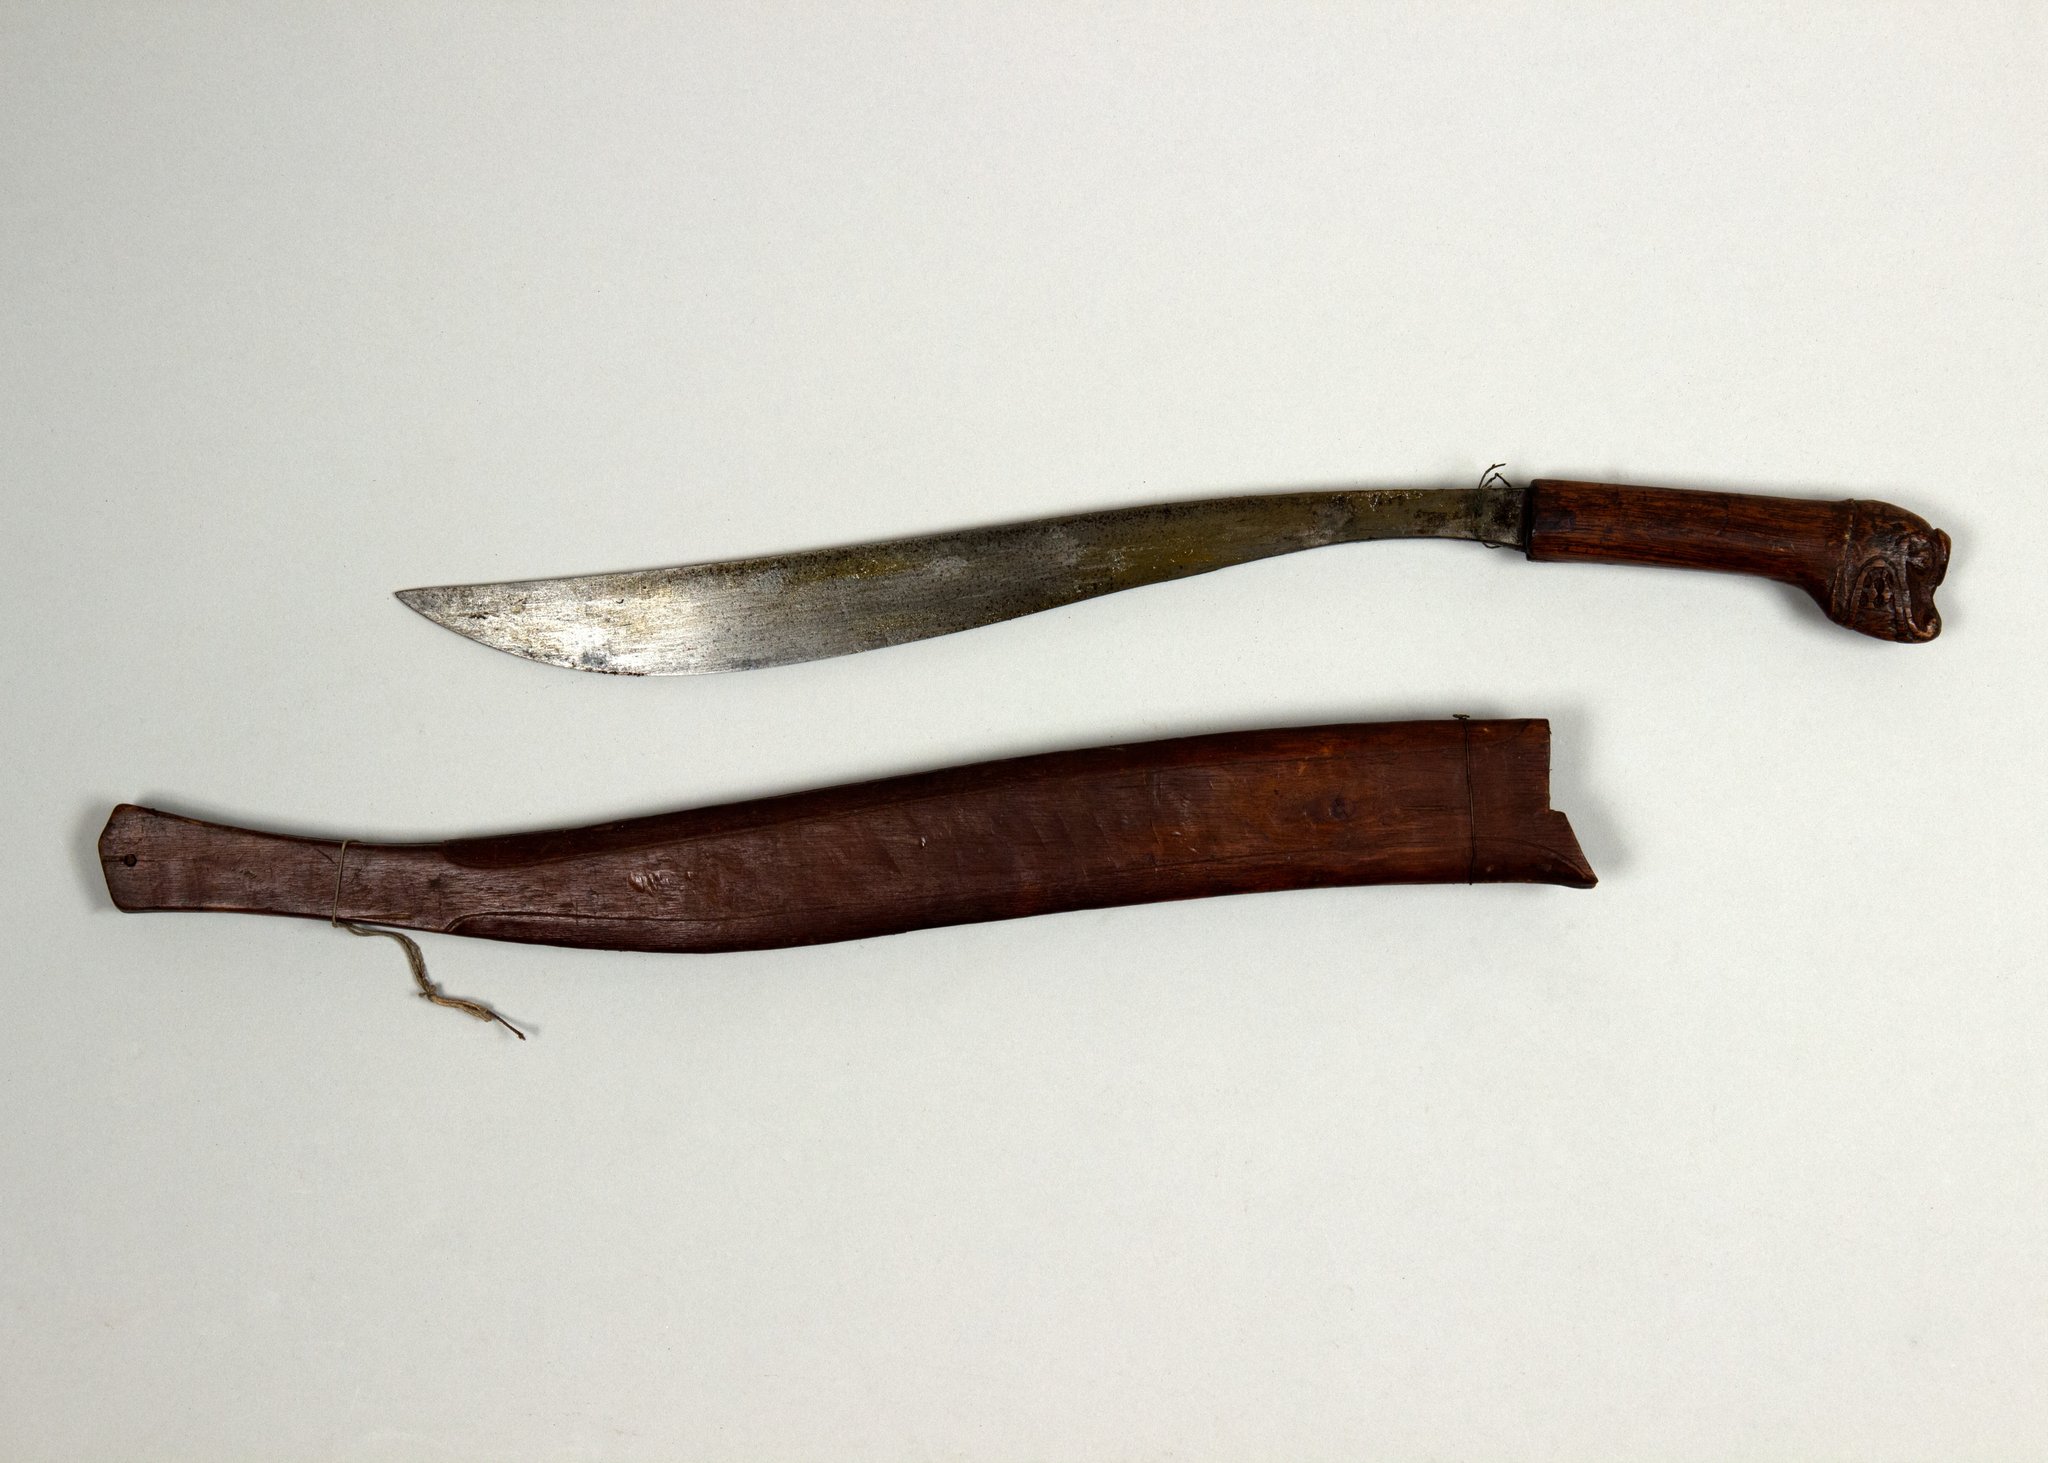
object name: jungle knife parang with sheath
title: Jungle Knife (Parang) with Sheath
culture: malayan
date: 1701-1900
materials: wood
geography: malaysia